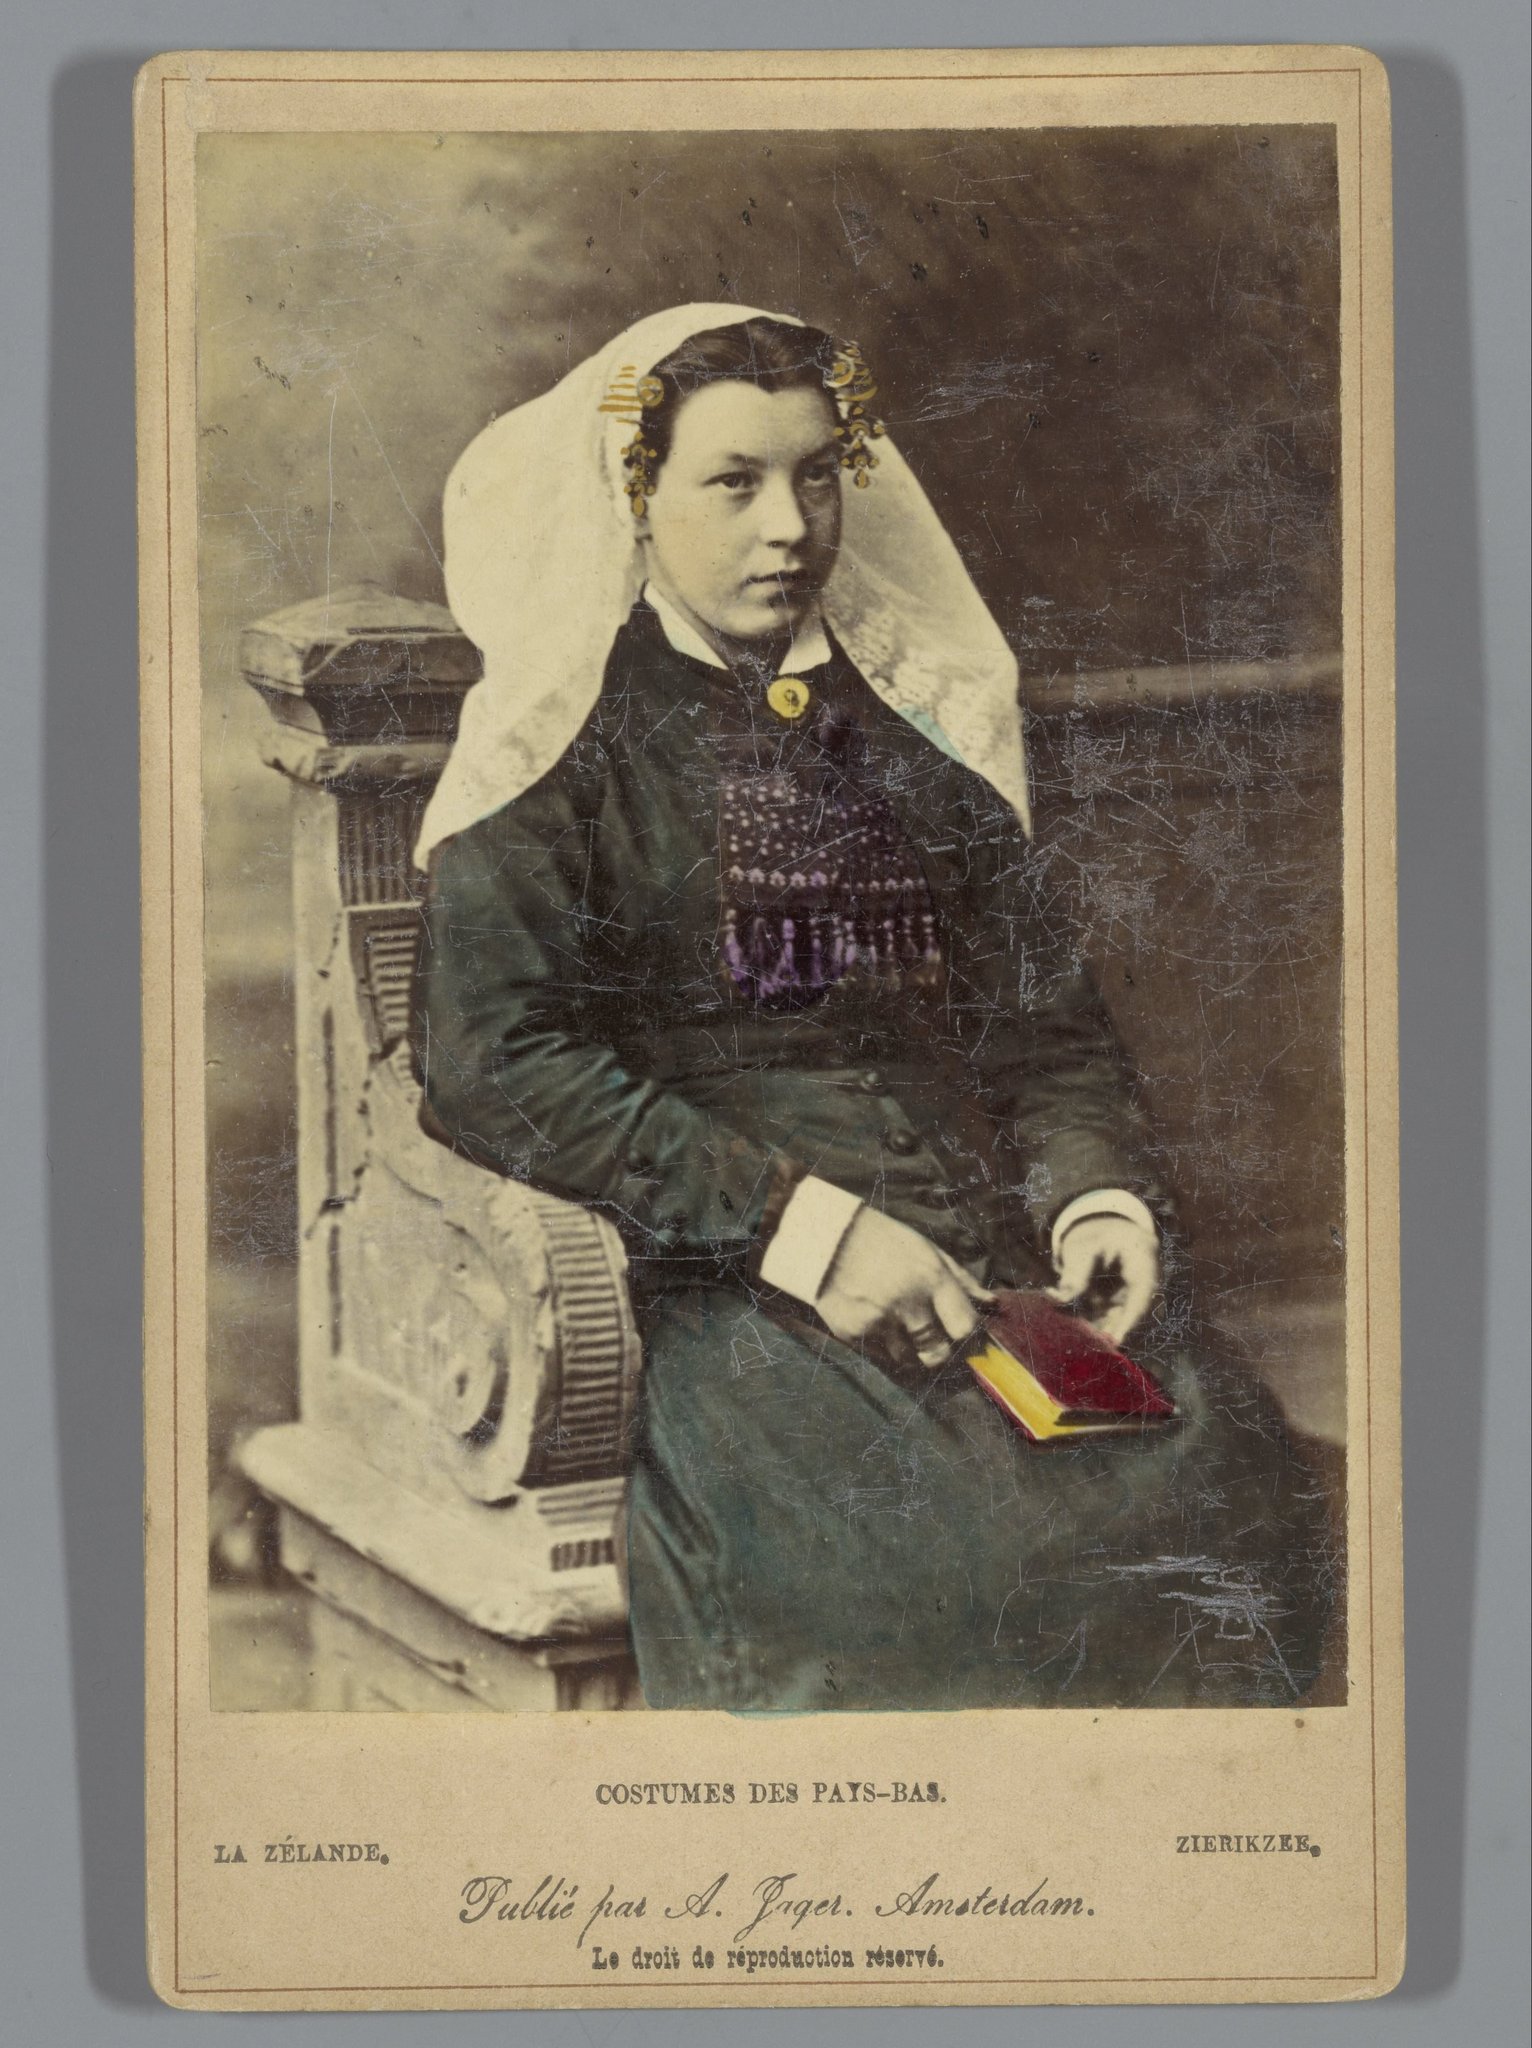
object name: cabinet photograph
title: Costumes des Pays-Bas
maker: andries jager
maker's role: publisher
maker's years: 1825-1905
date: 1860-1890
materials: cardboard, photographic support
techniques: albumen print, hand coloring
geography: amsterdam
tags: historical persons not known by name - bb - woman, folk costume, regional costume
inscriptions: inscription: ‘Publié par A. Jager, Amsterdam./ Le droit de réproduction réservé.’